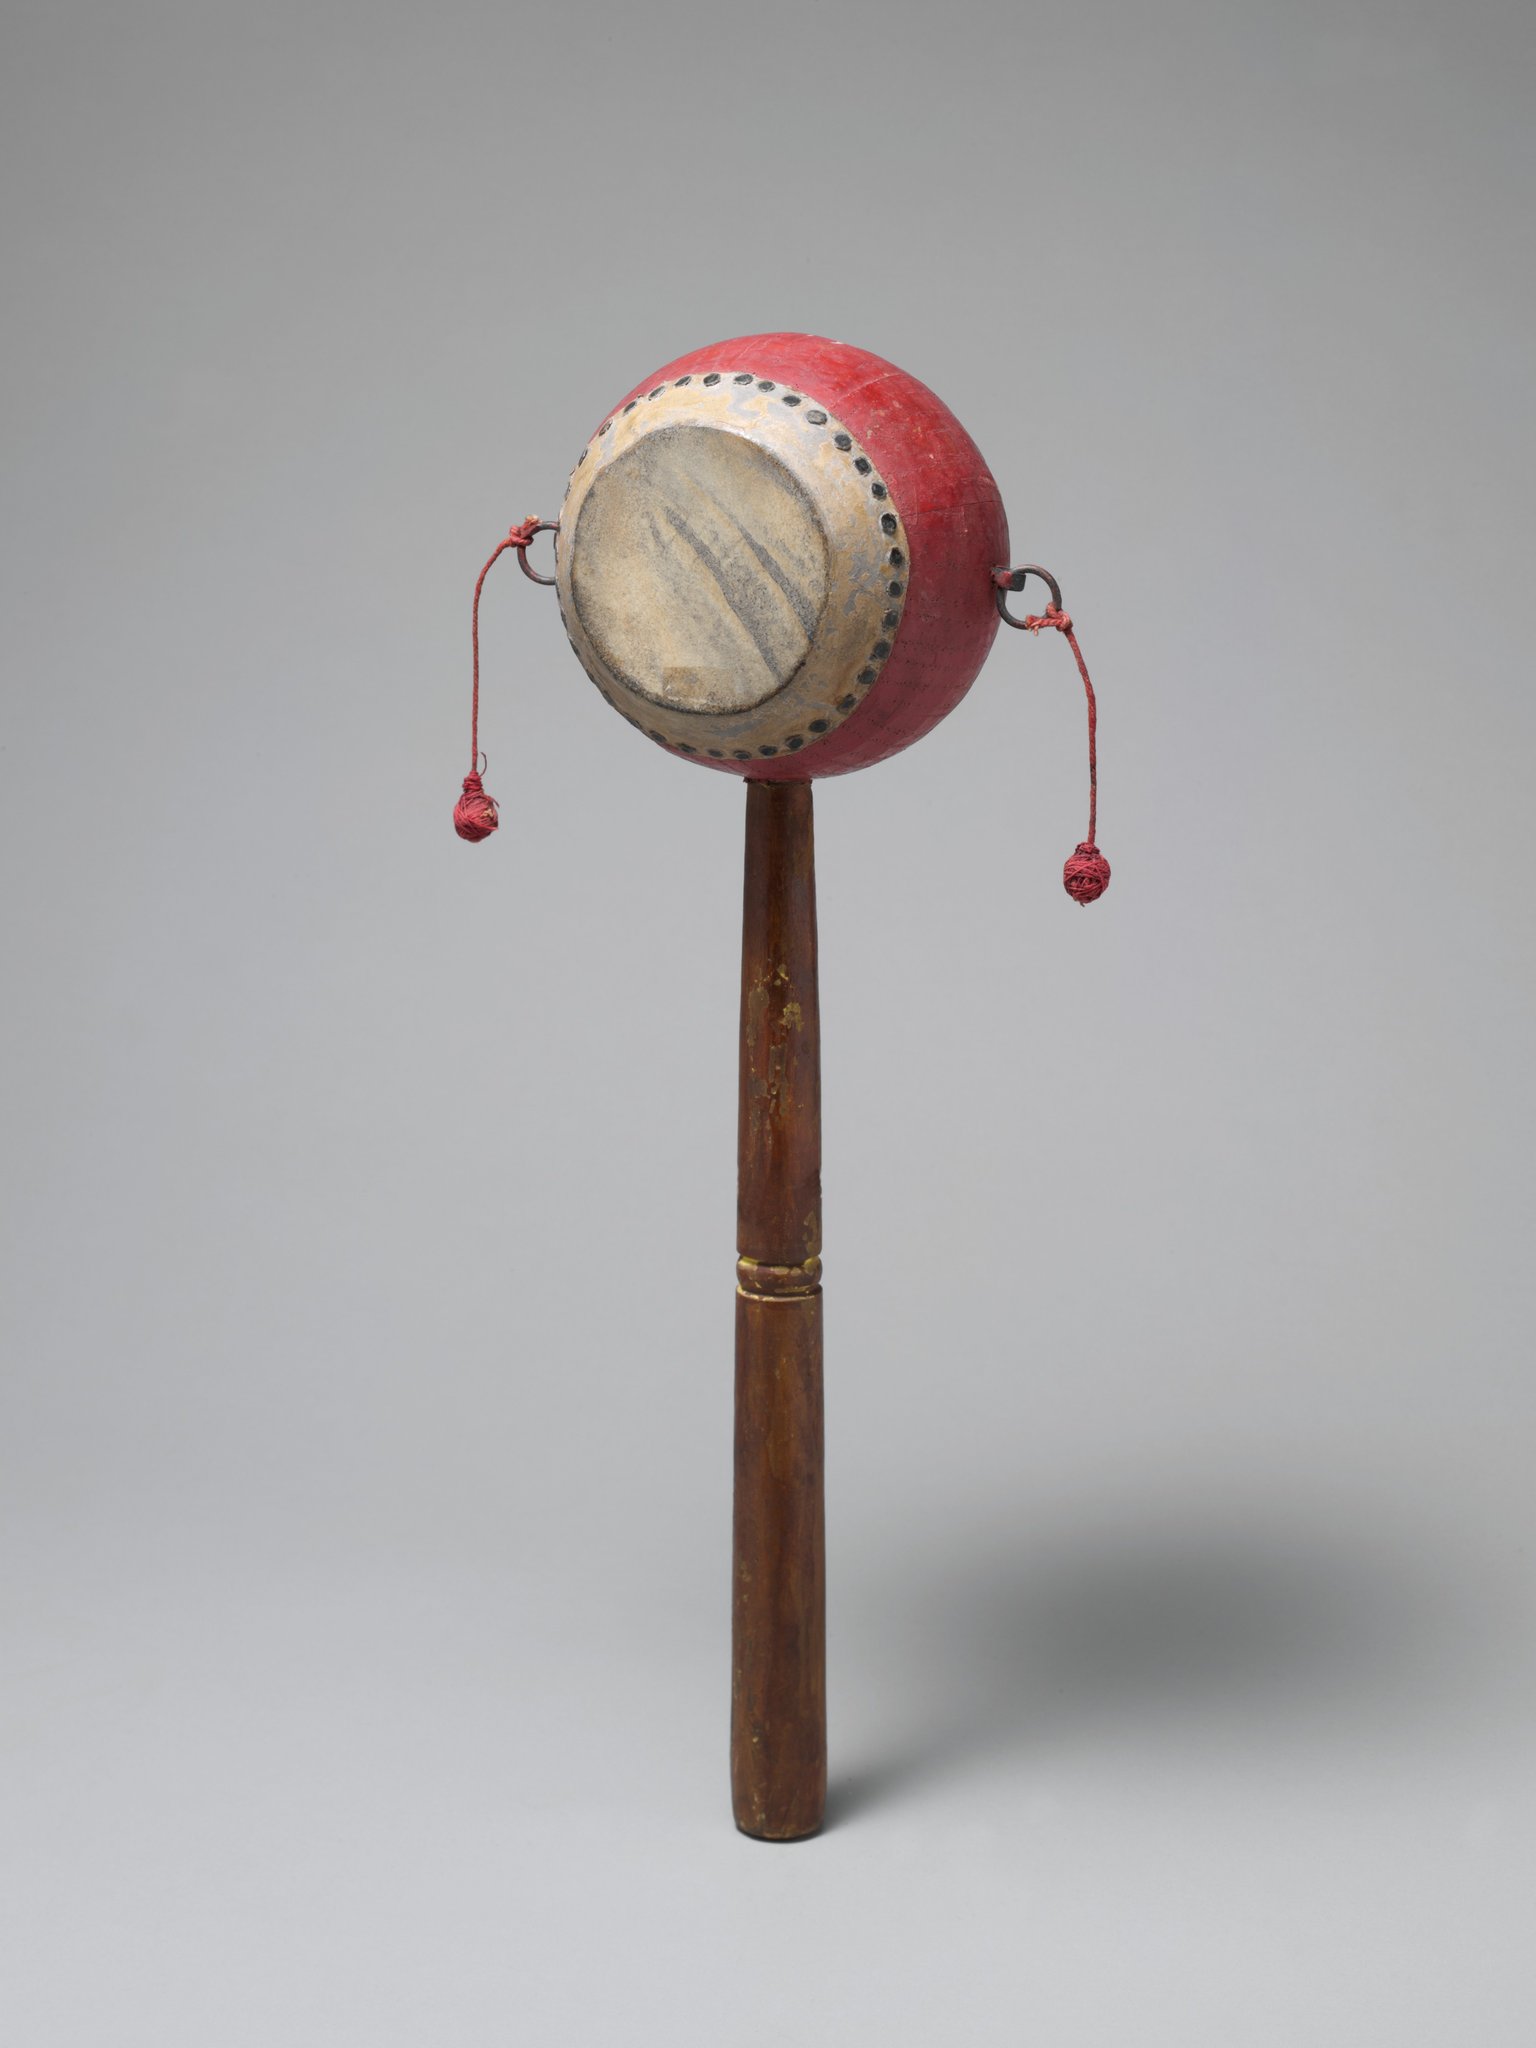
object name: taogu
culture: chinese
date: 1867-1900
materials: cord, wood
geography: china